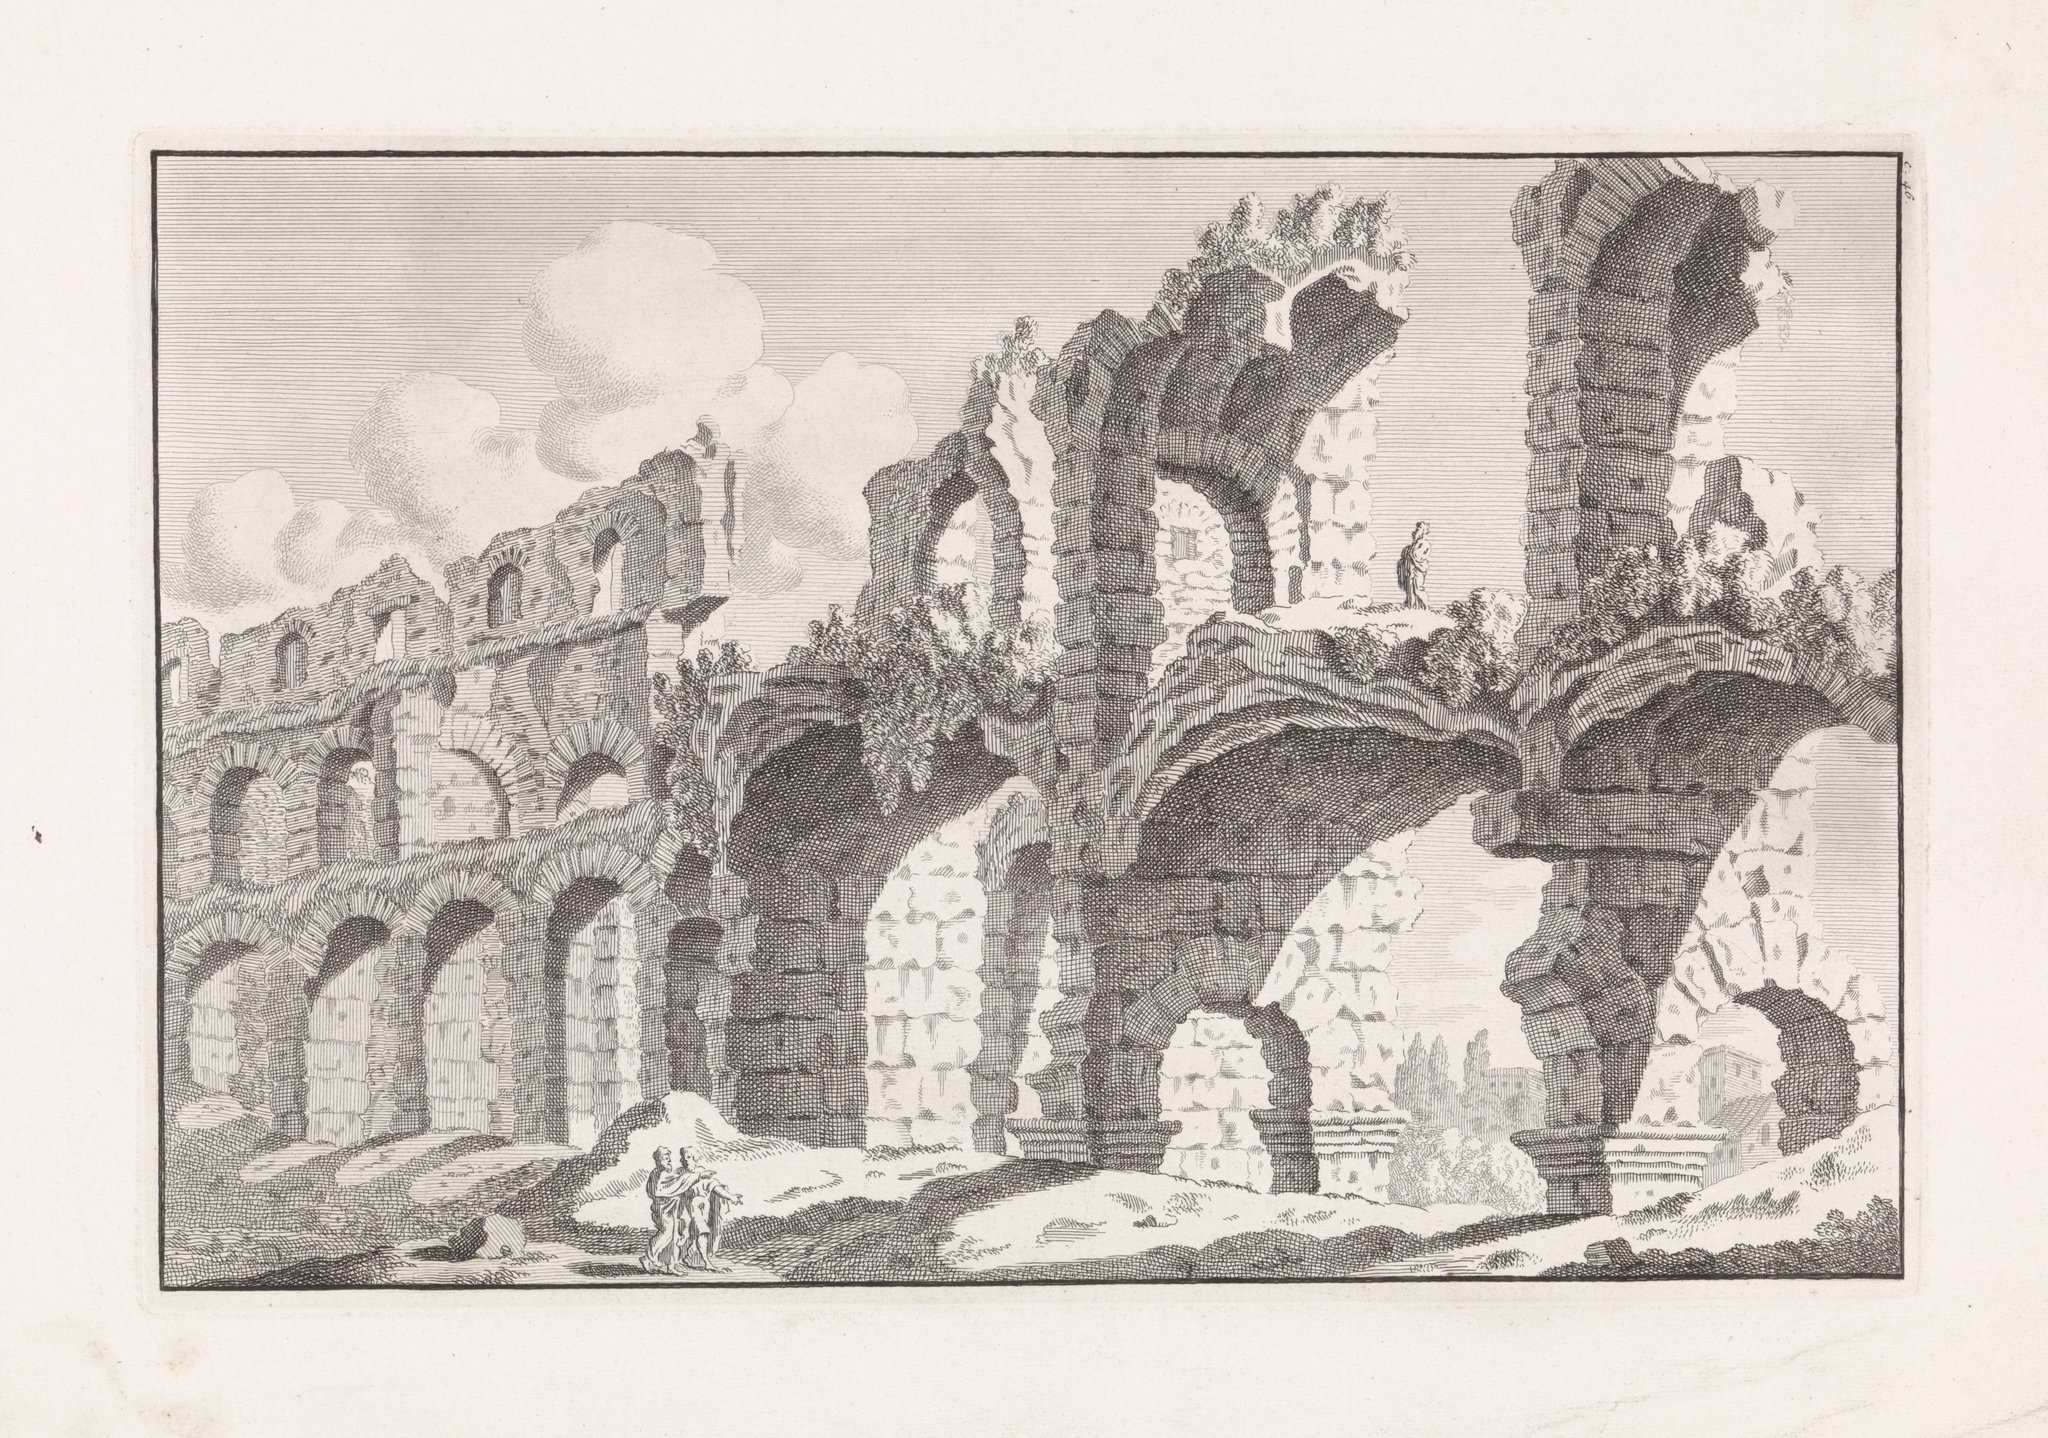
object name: print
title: Ruïnes van het colosseum in Rome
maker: bonaventura van overbeek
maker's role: draughtsman, print maker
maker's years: 1660-1706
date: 1708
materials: paper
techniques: etching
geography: amsterdam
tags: ruin of a building ~ architecture, rome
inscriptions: collector's mark: Lugt 2228